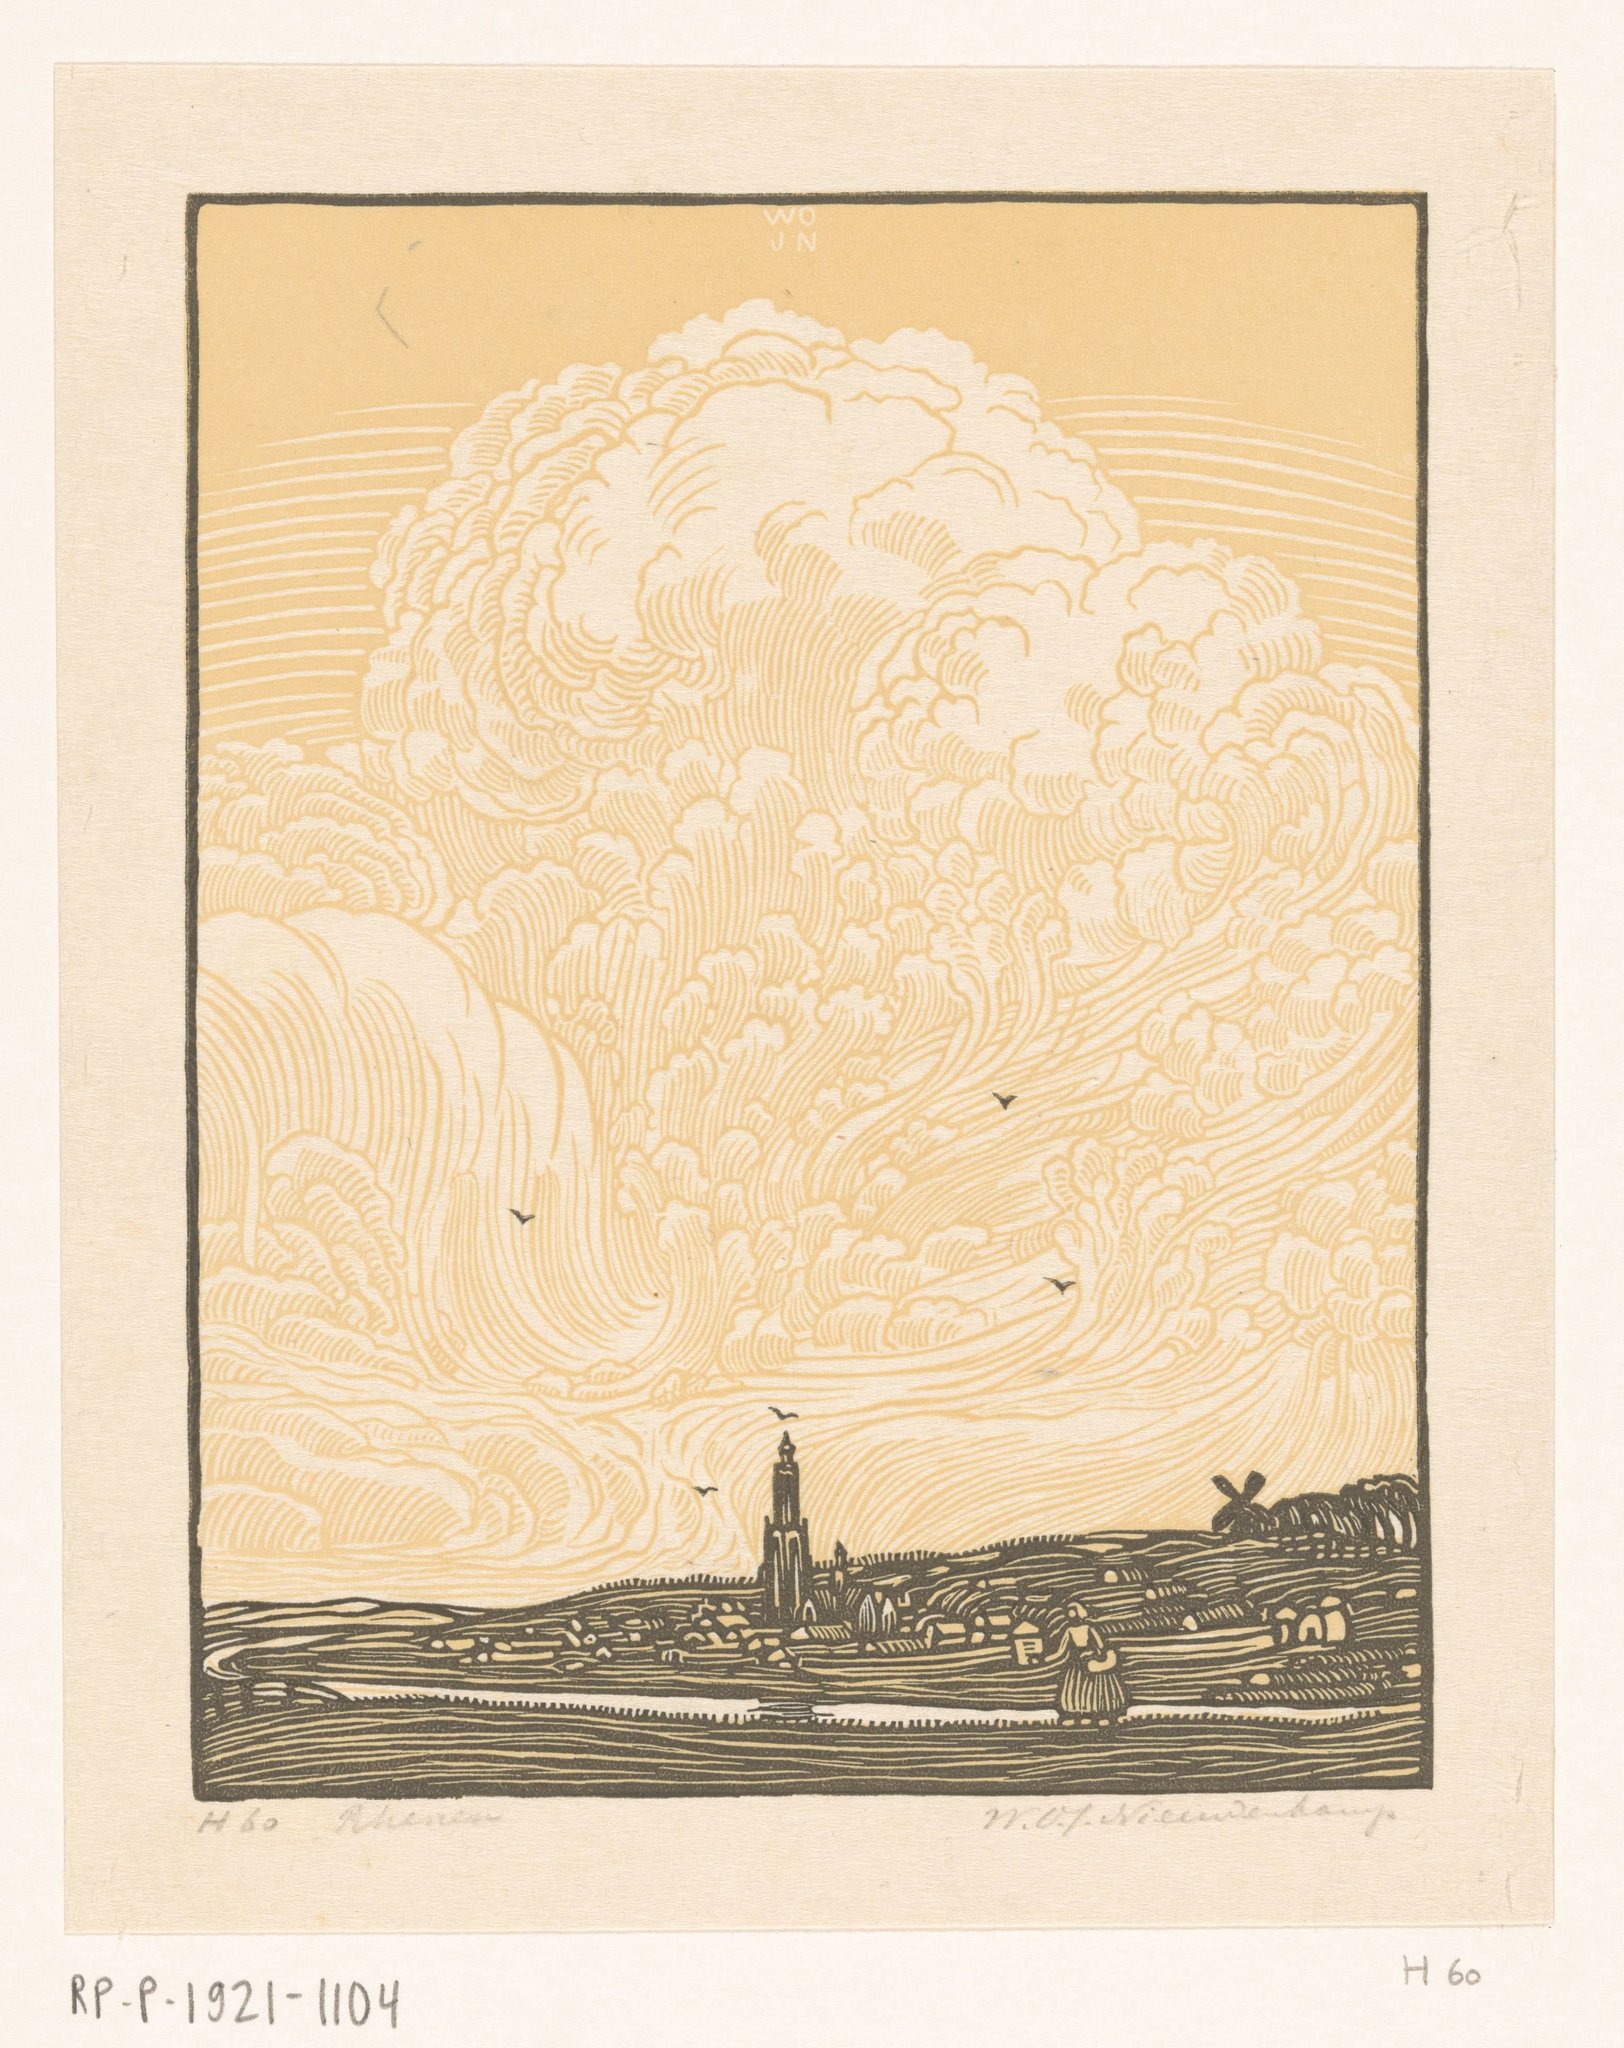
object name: print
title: Rhenen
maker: wijnand otto jan nieuwenkamp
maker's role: draughtsman, print maker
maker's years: 1874-1950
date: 1903-1905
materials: paper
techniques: woodcut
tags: city-view, and landscape with man-made constructions, river, clouds, rhenen, lower rhine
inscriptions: collector's mark: Lugt 2233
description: Een gezicht op Rhenen vanuit de Betuwe. Op de voorgrond een vrouw die wandelt langs de Rijn. Op de achtergrond Rhenen met in het midden de Cuneratoren en rechts de Binnenmolen. Boven de stad wolken.